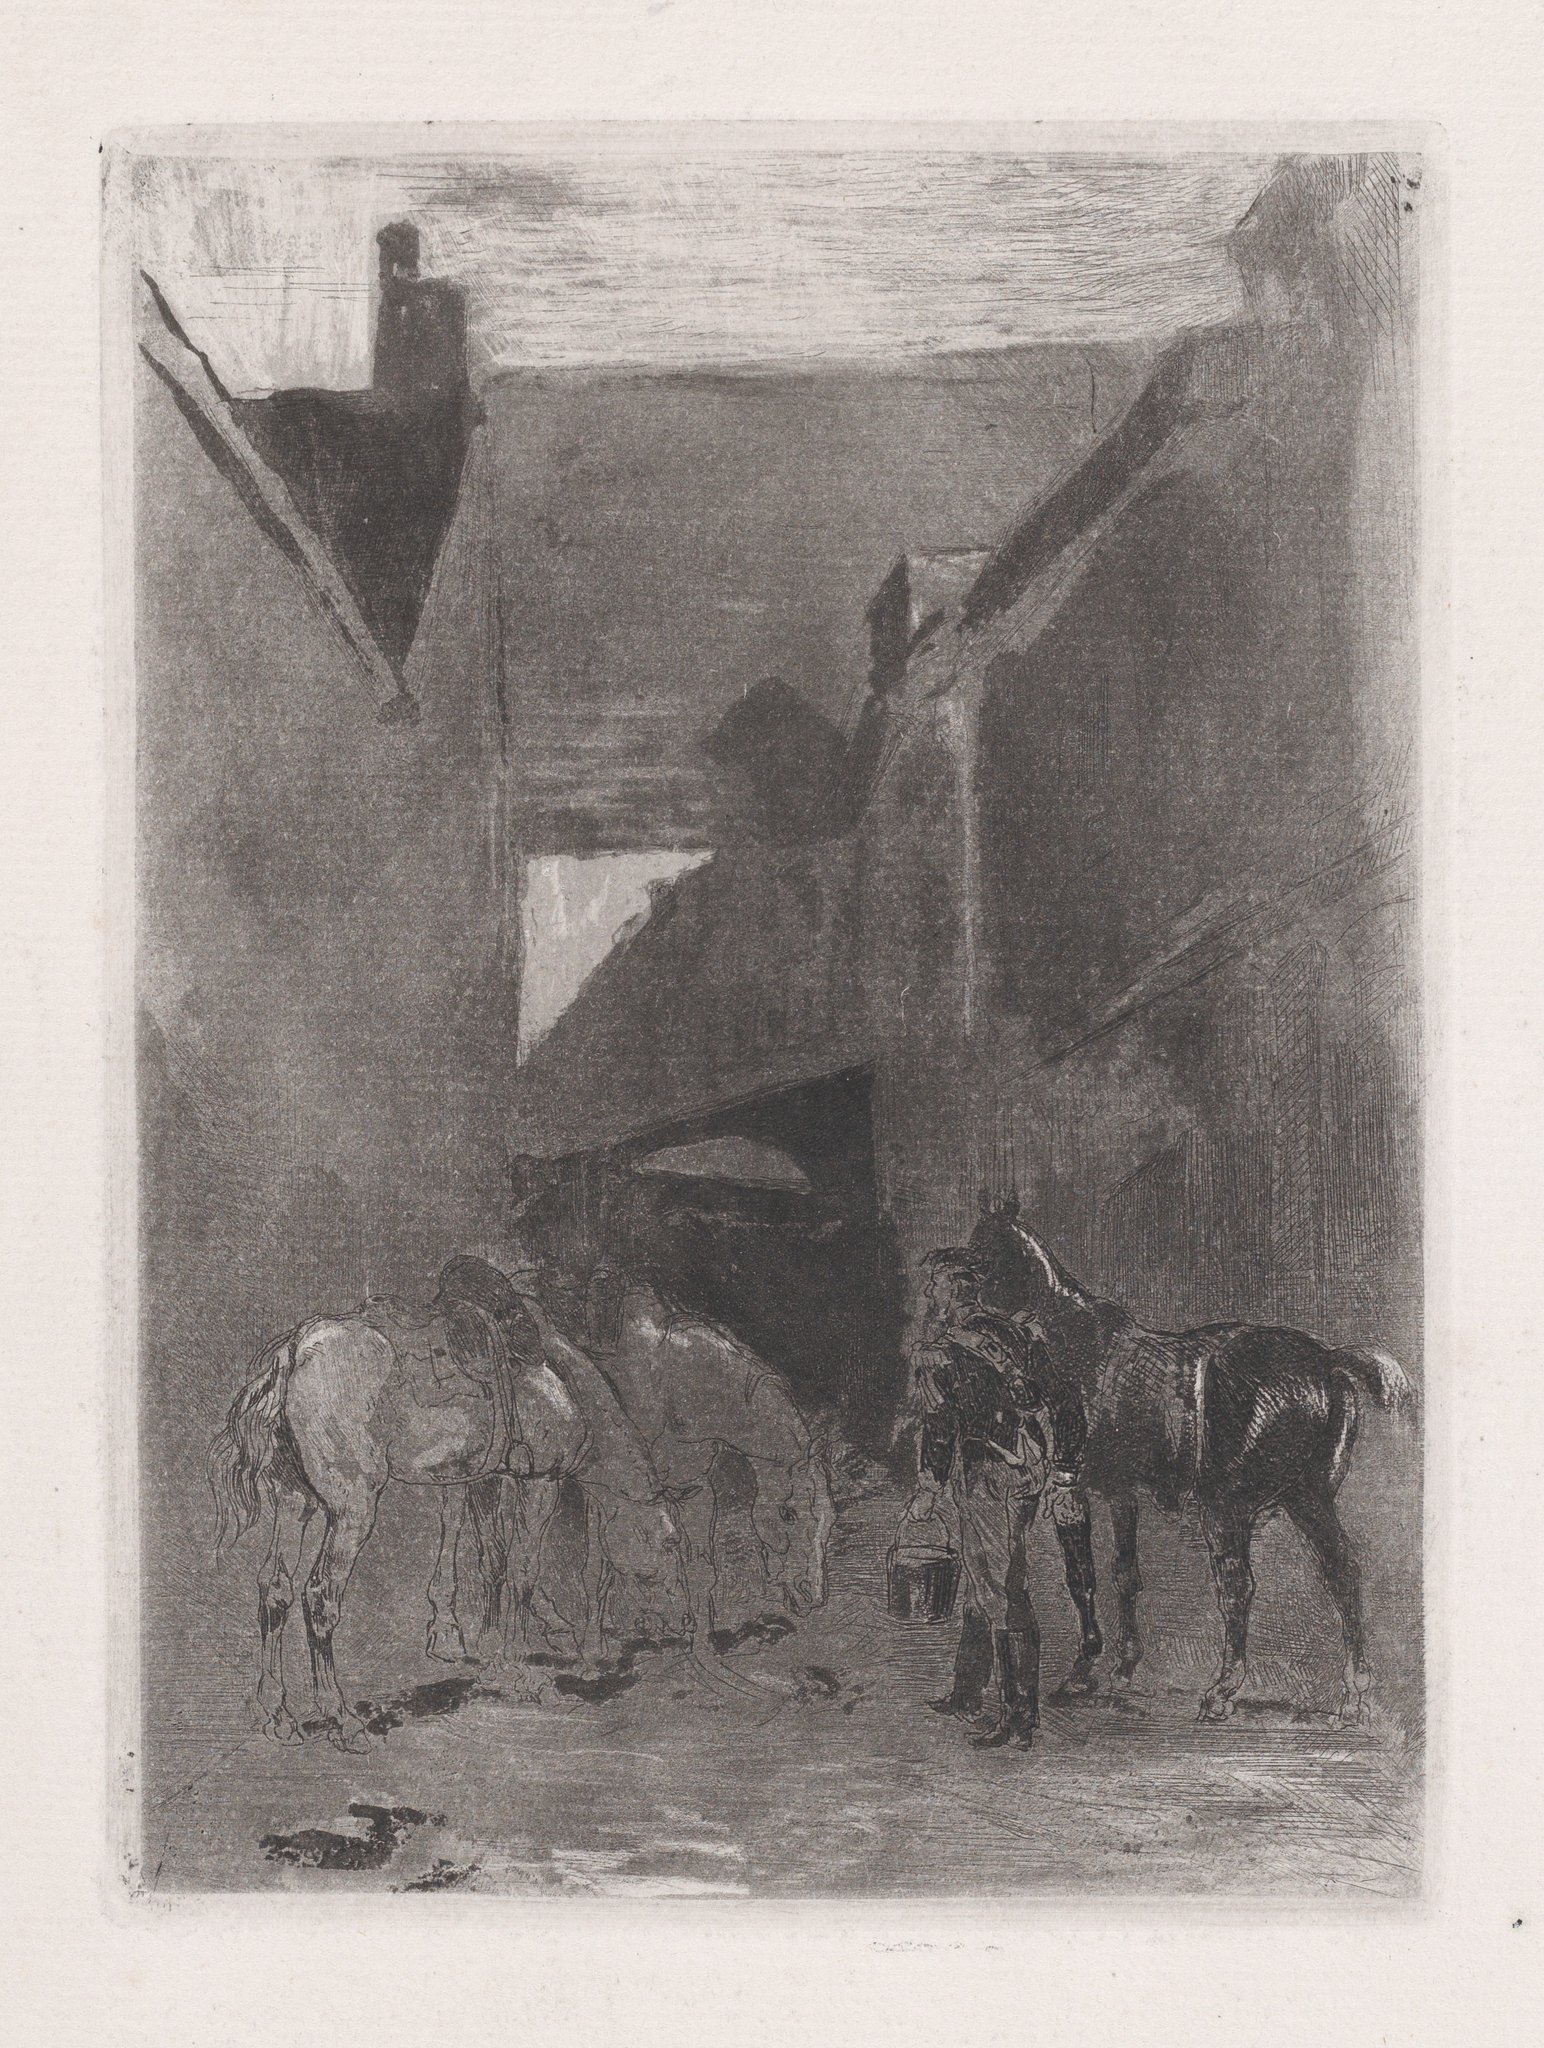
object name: print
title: Cour de Caserne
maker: john-lewis brown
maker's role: artist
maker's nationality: french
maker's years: 1829-1890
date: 1801-1900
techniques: aquatint